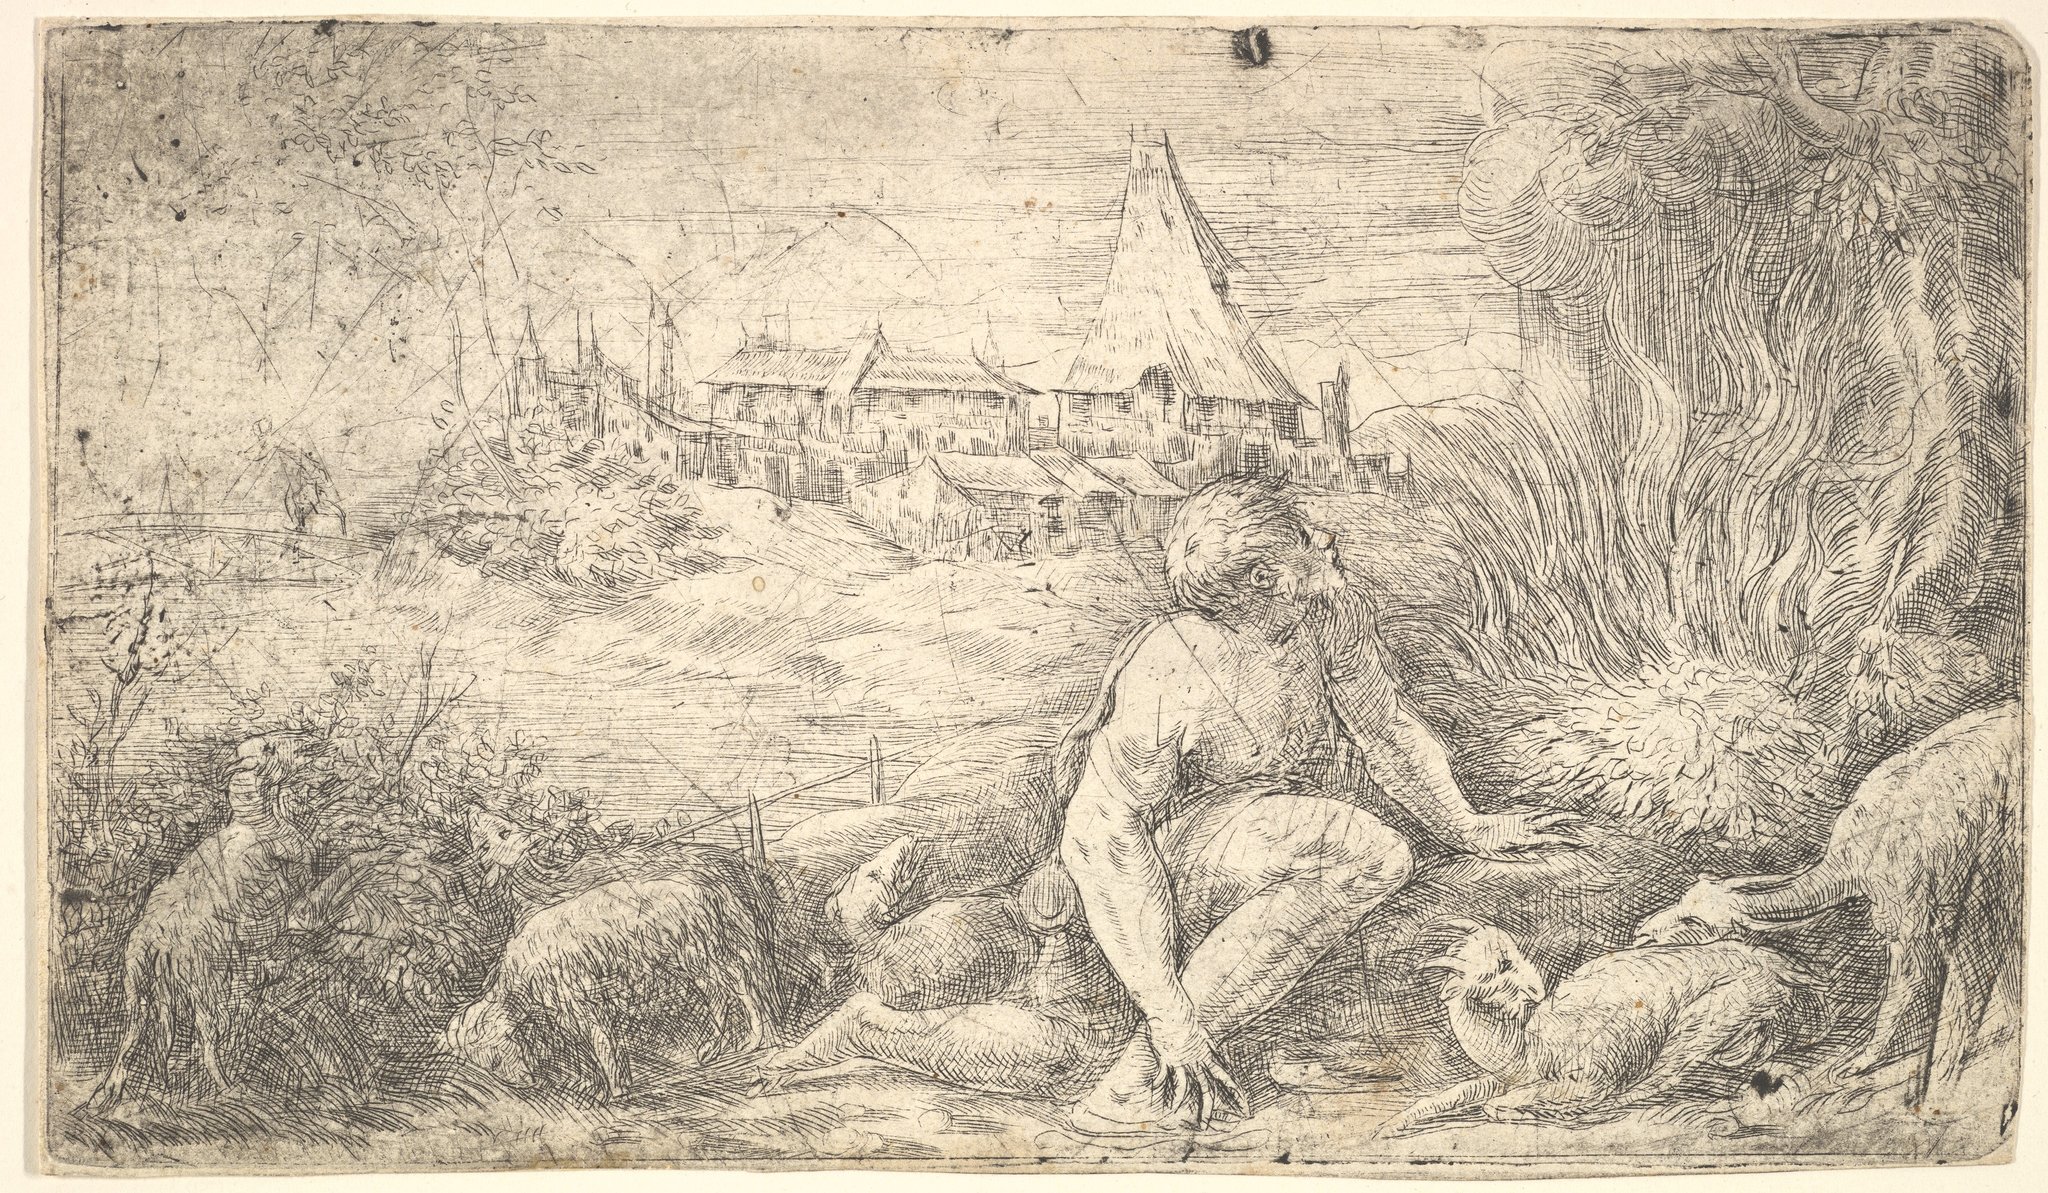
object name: print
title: Moses and the burning bush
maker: andrea schiavone (andrea meldola)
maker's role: artist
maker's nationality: italian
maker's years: 1510-1563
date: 1544-1547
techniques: etching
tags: houses,fire,moses